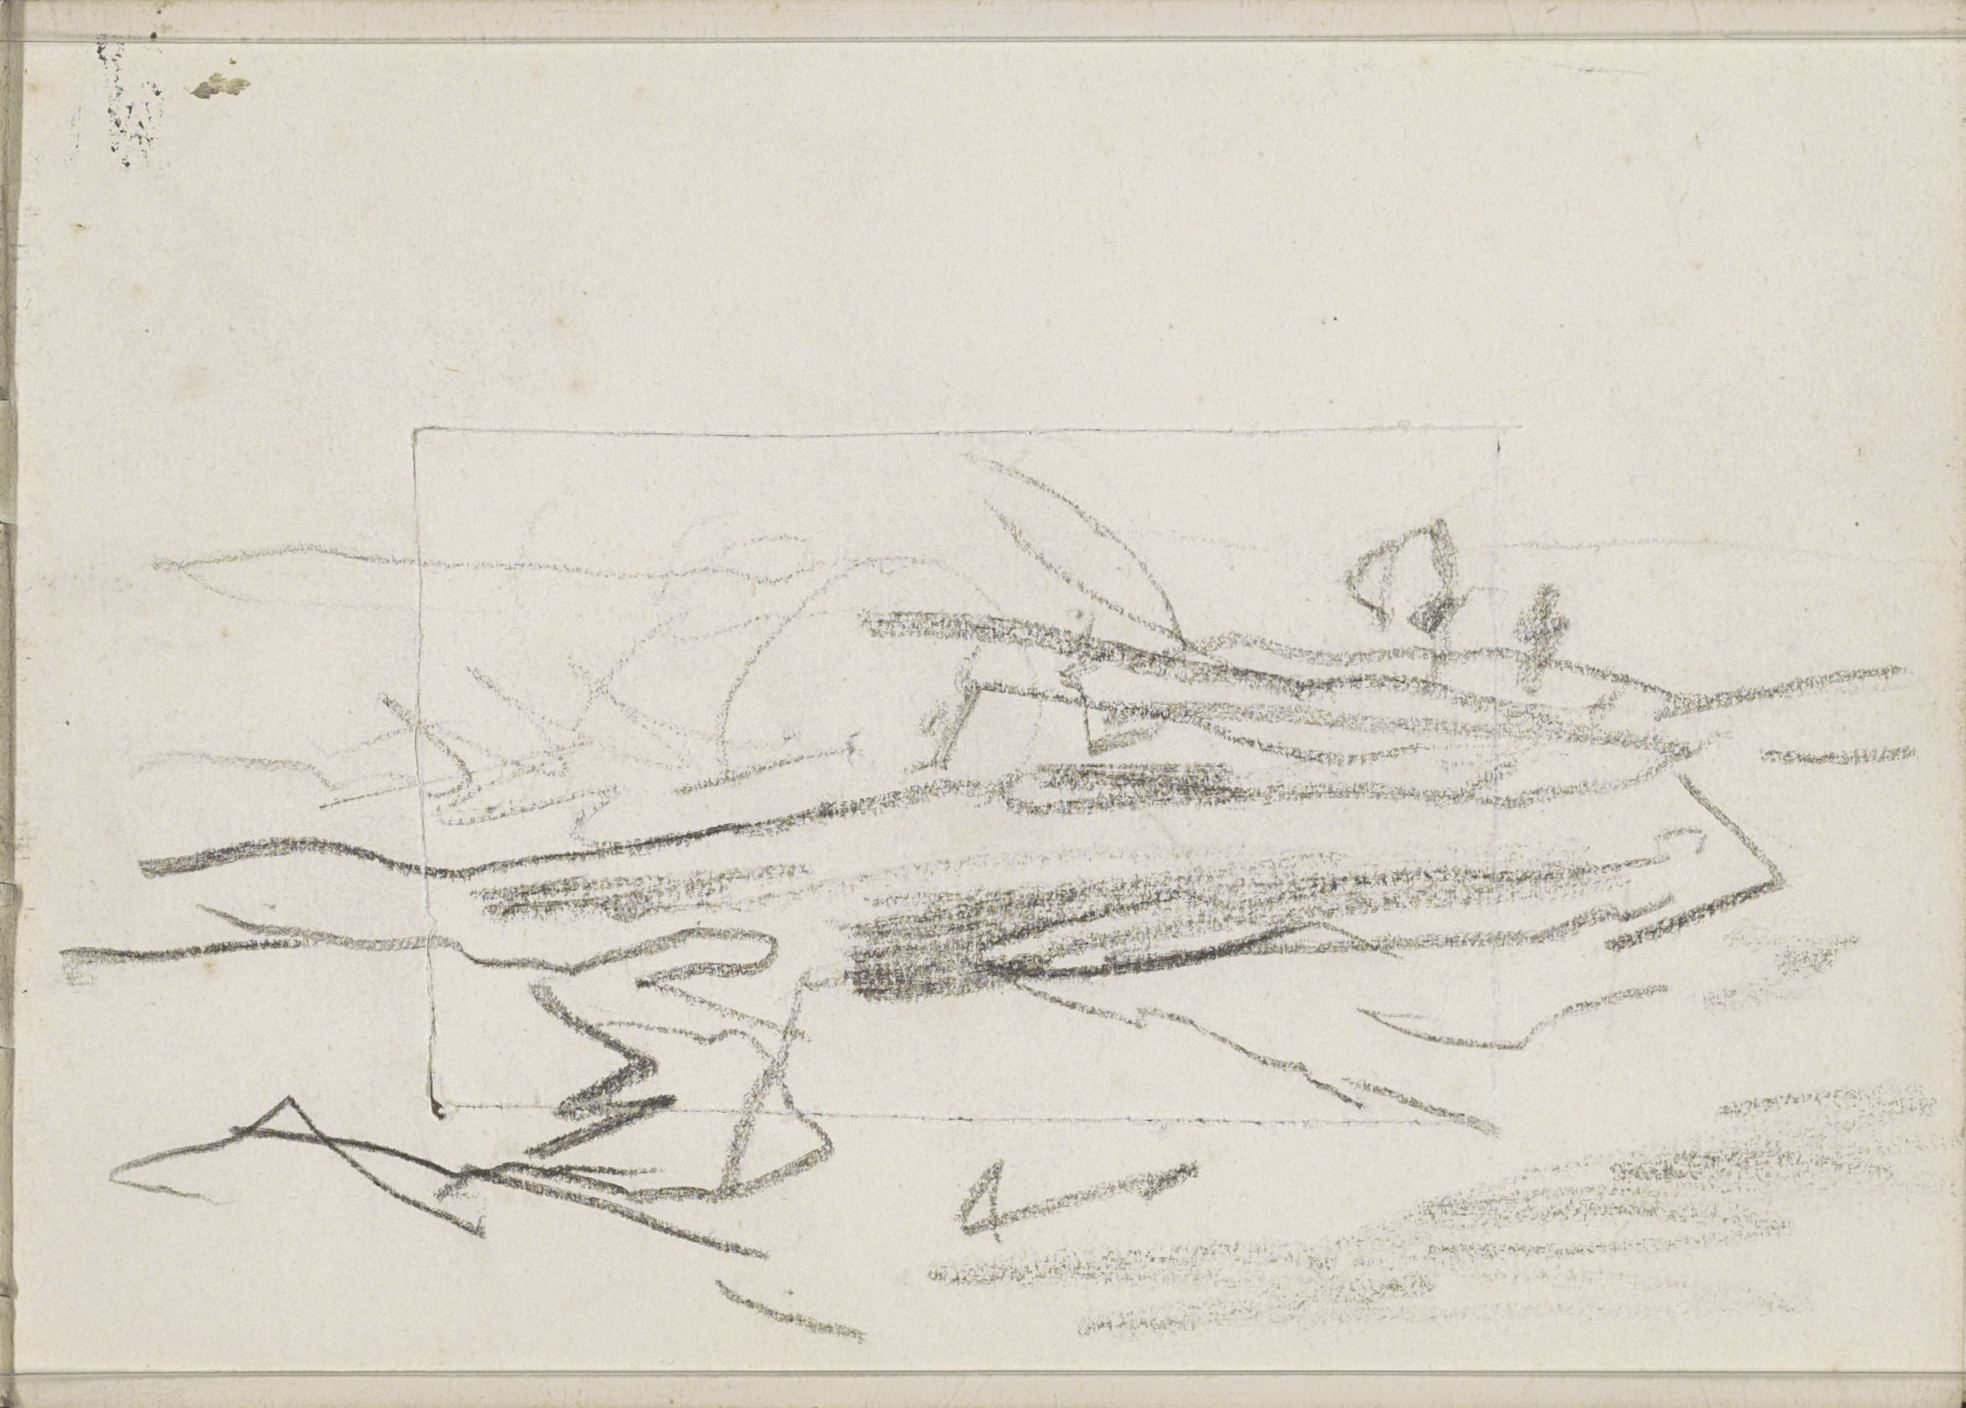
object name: sketchbook leaf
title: Studie, mogelijk omgehakte boomstammen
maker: anton mauve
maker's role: draughtsman, painter, print maker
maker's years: 1838-1888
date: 1848-1888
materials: chalk, paper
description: Blad 21 recto uit een schetsboek met 31 bladen.